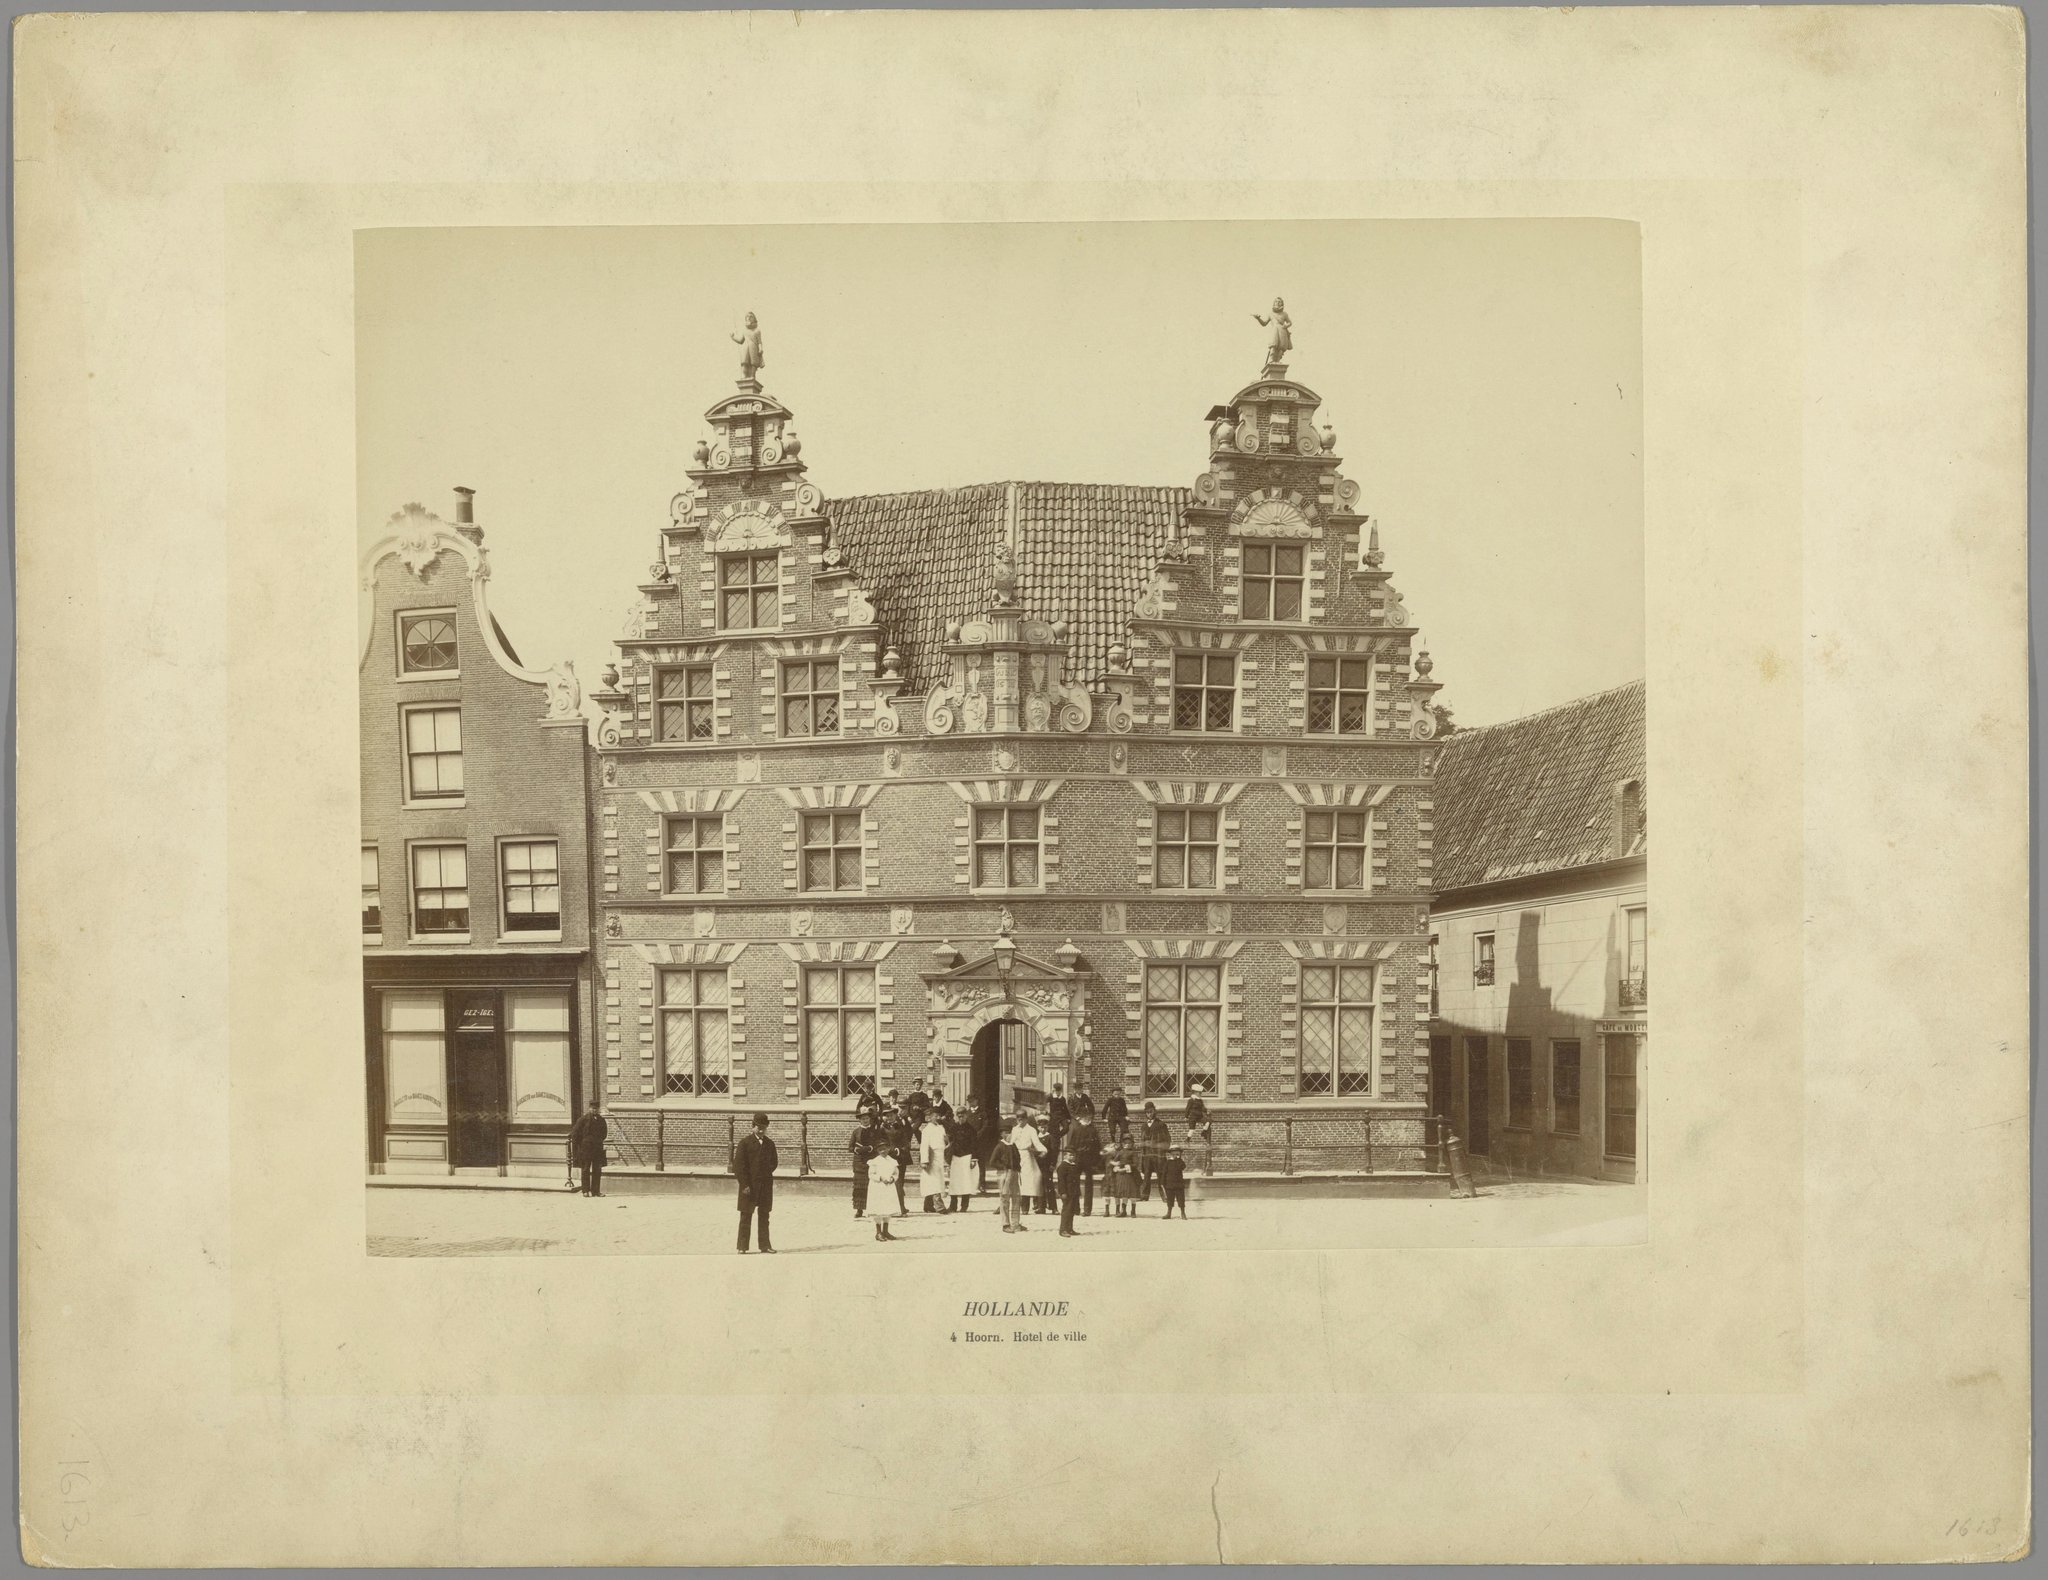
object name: photograph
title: Exterieur van het stadhuis (Het Statenlogement) te Hoorn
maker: Anonymous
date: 1875-1900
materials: cardboard, photographic support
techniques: albumen print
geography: hoorn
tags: townhall, street (+ city(-scape) with figures, staffage)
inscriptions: inscription: ‘1613.’, inscription: ‘H 11.’, collector's mark: ‘RIJKS-NORMAALSCHOOL-VOOR-TEEKENONDERWIJZERS-AMSTERDAM’